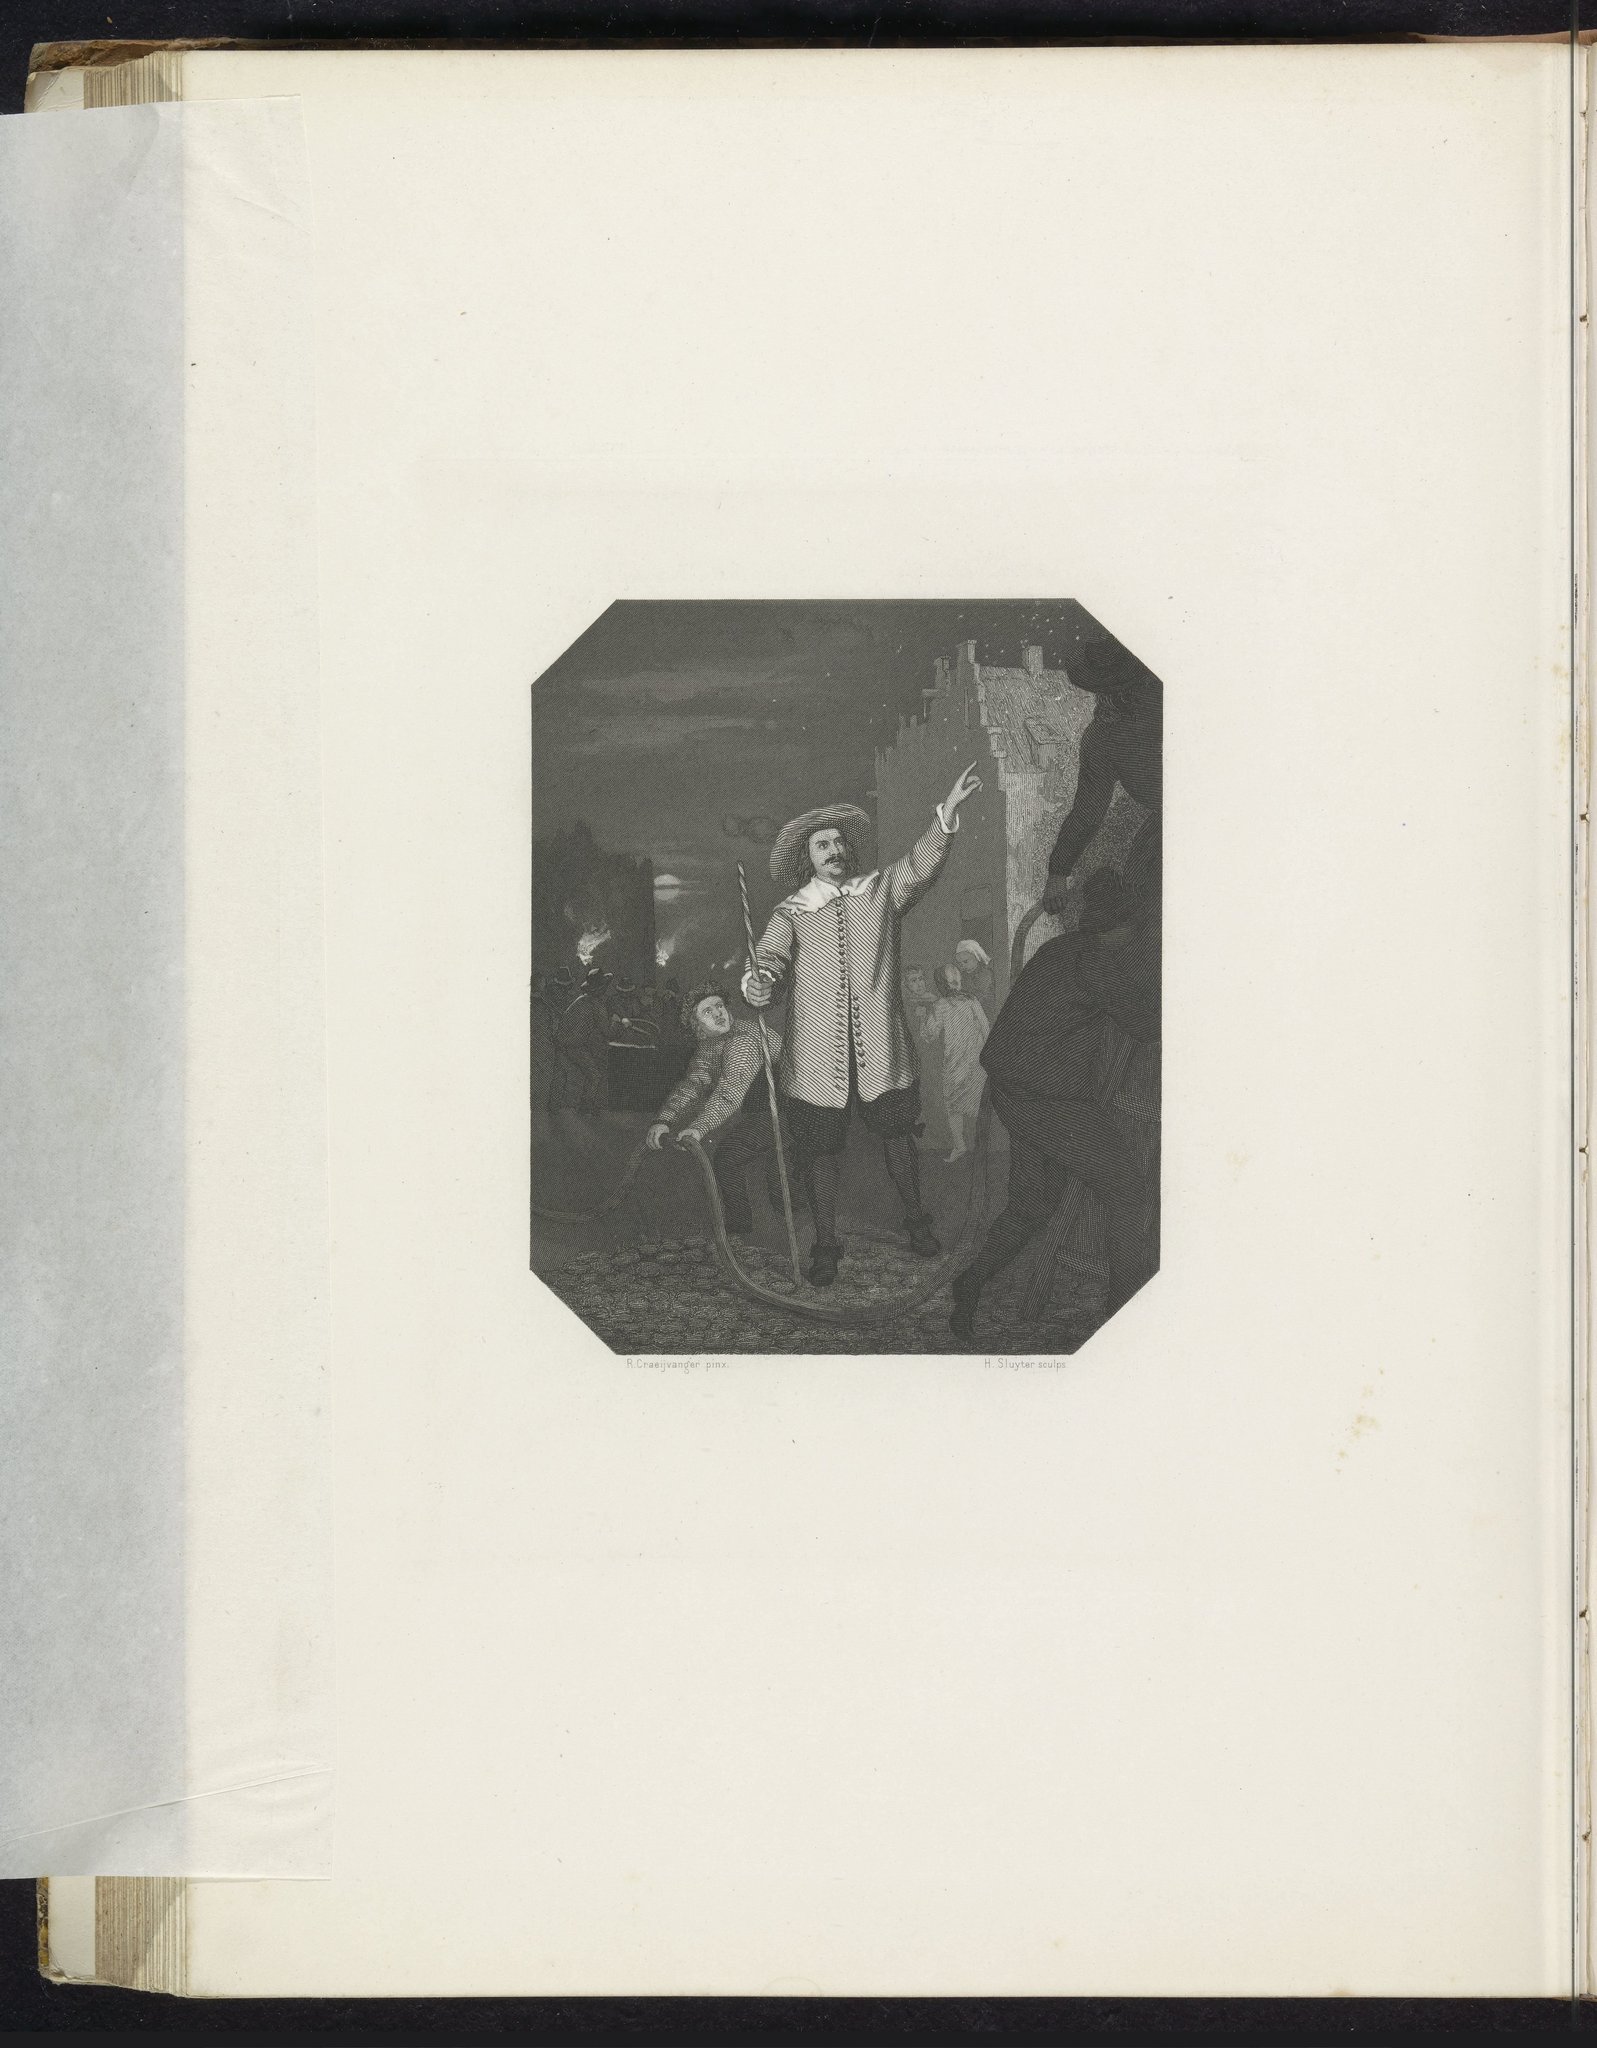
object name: history print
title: Jan van der Heyden, ca. 1673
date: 1865-1870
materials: paper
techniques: engraving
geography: netherlands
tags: amsterdam, painter, print maker, draughtsman, jan van der heyden, pump (fire-extinguishing equipment)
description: Jan van der Heyden bij het blussen van een brand, ca. 1673. Onderdeel van de groep staalgravures naar de schilderijen van de Historische Galerij der Maatschappij Arti et Amicitiae.